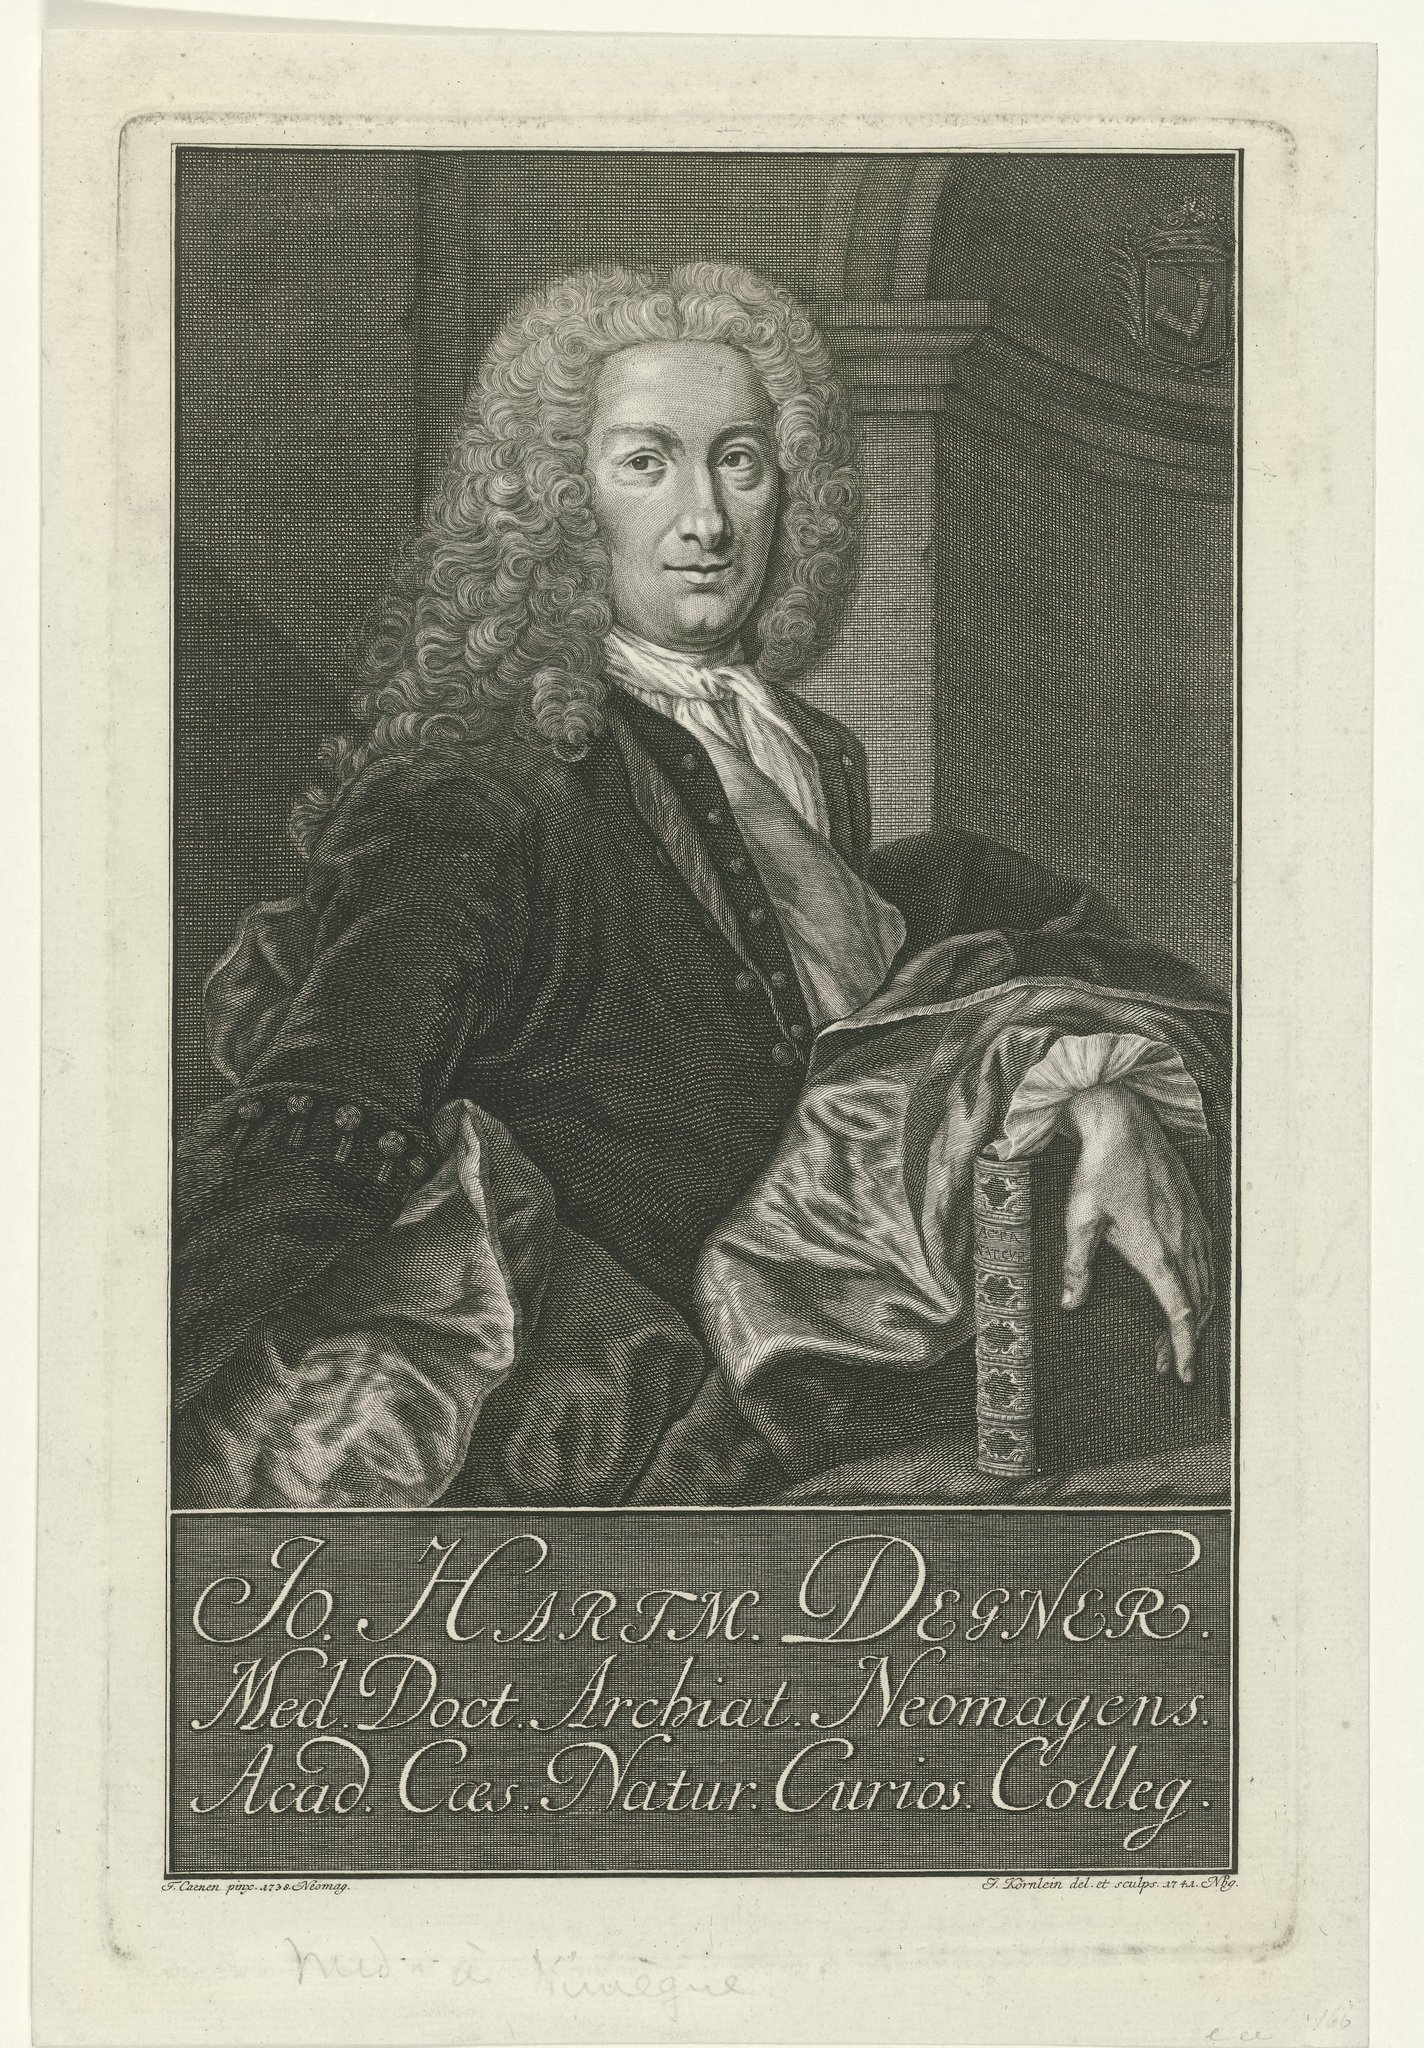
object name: print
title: Portret van Jan Hartmann Degner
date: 1741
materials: paper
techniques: engraving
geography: amsterdam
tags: nijmegen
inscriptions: collector's mark: Lugt 2228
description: Portret ten halven lijve naar rechts van Jan Hartmann Degner, geneesheer te Nijmegen. Degner draagt een pruik en heeft zijn linkerhand over een boek gelegd. Rechts het familiewapen en in de marge een drieregelige tekst.